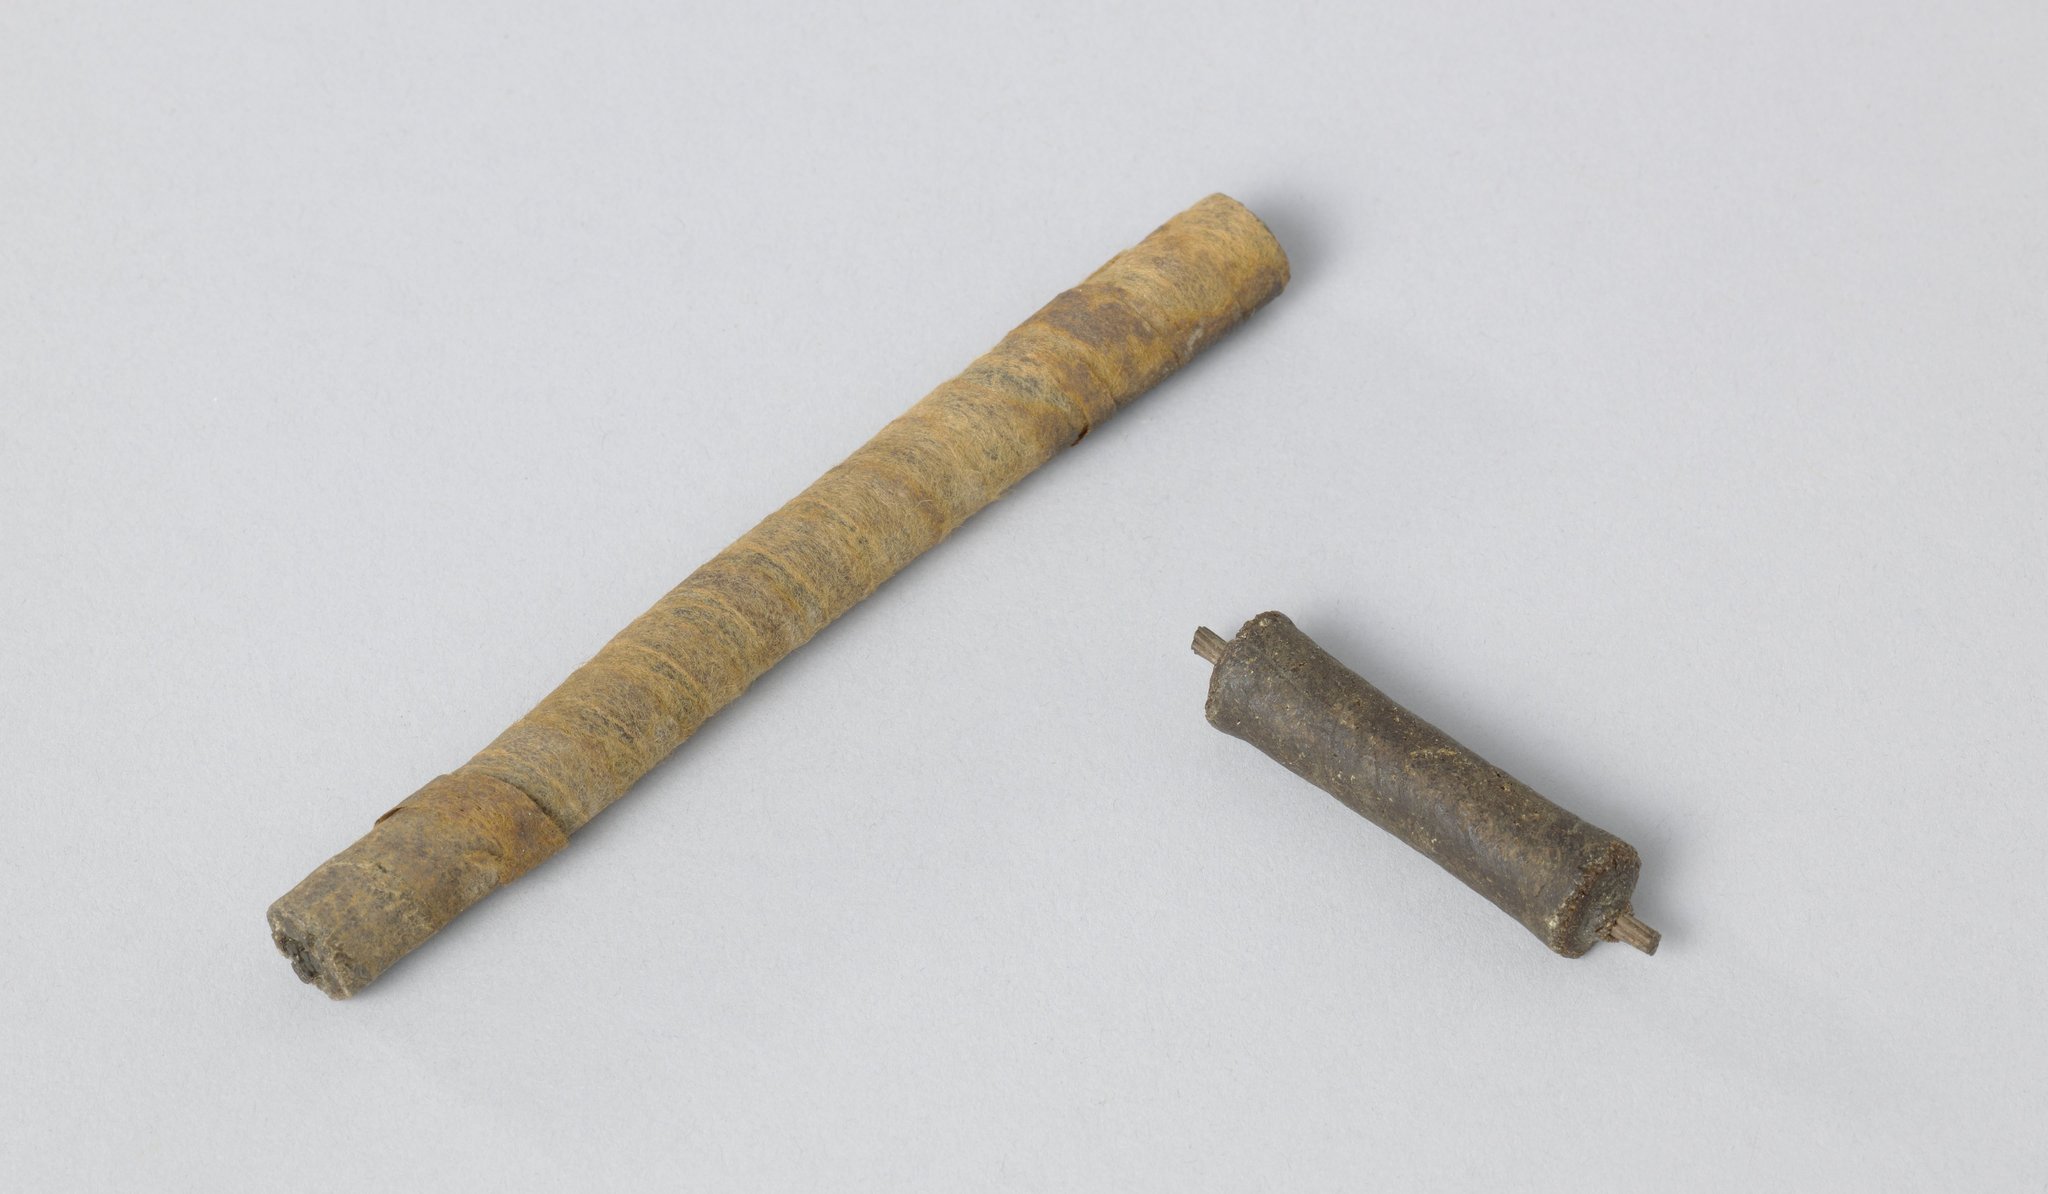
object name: sample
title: Sample of Telegraph Cable for Mines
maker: Anonymous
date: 1865-1875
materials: copper, paper, plastic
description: Oorspronkelijk hoorden er vijf monsters te zijn. Dit soort kabel werd gebruikt om de mijn elektrisch tot ontsteking te brengen.